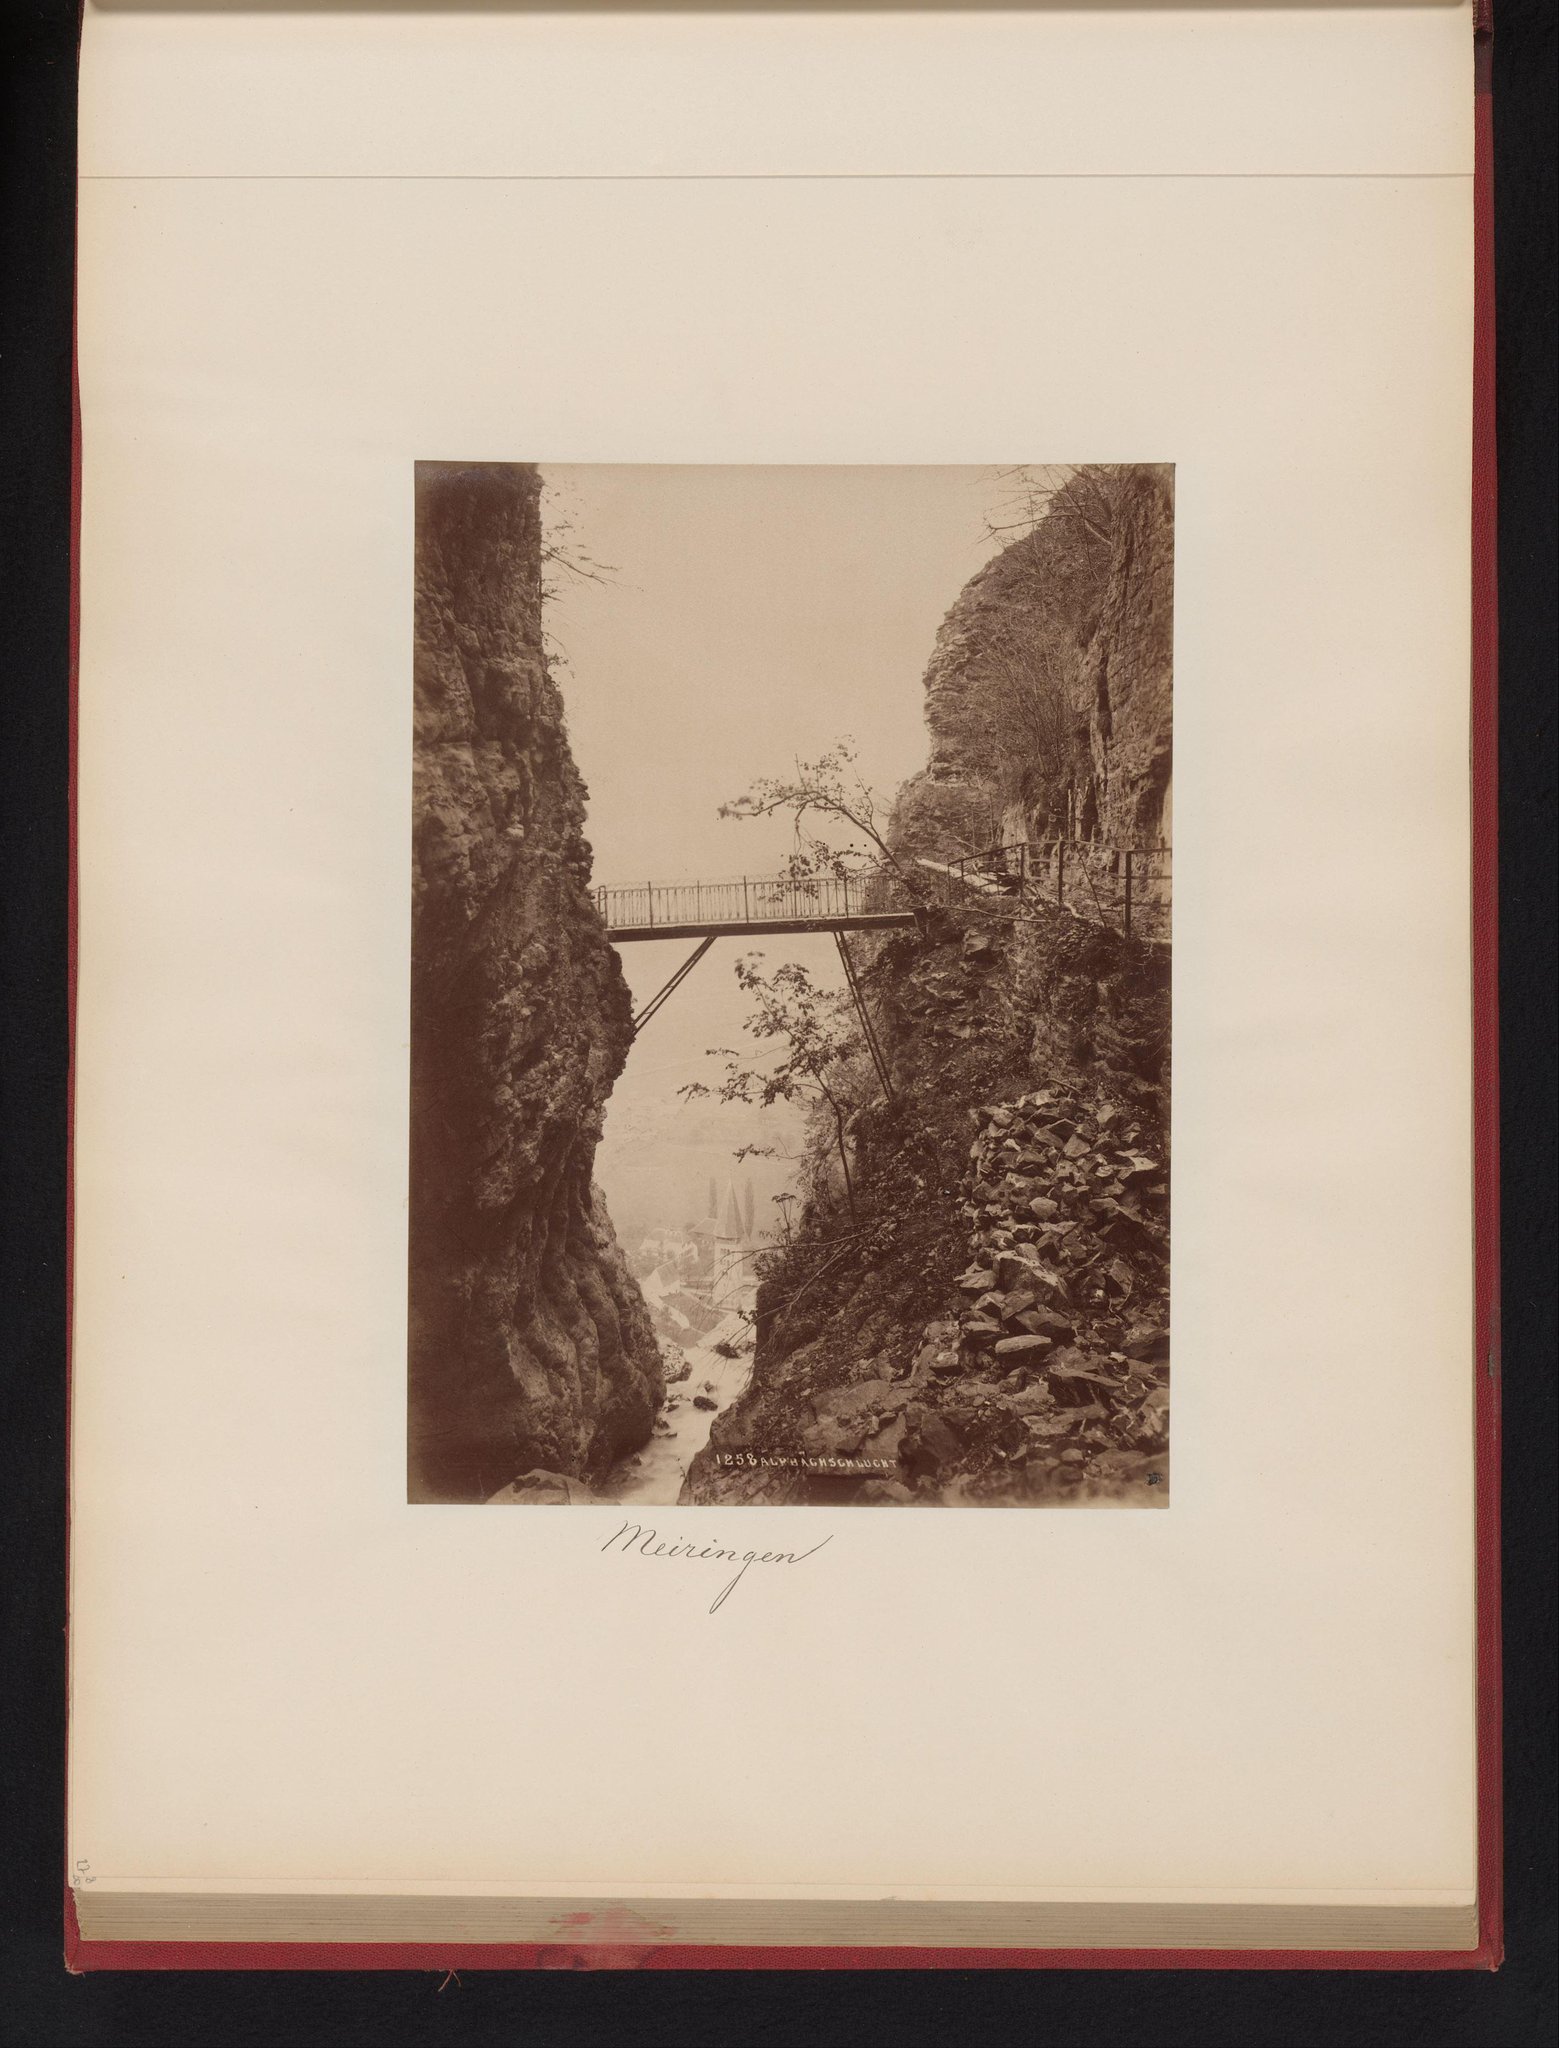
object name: album leaf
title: Gezicht door de Alpbachschlucht te Meiringen, Zwitserland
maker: Anonymous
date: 1880-1900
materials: photographic support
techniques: albumen print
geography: meiringen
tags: ravine, chasm, abyss, canyon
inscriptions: inscription: ‘1258 Alpbachschlucht’